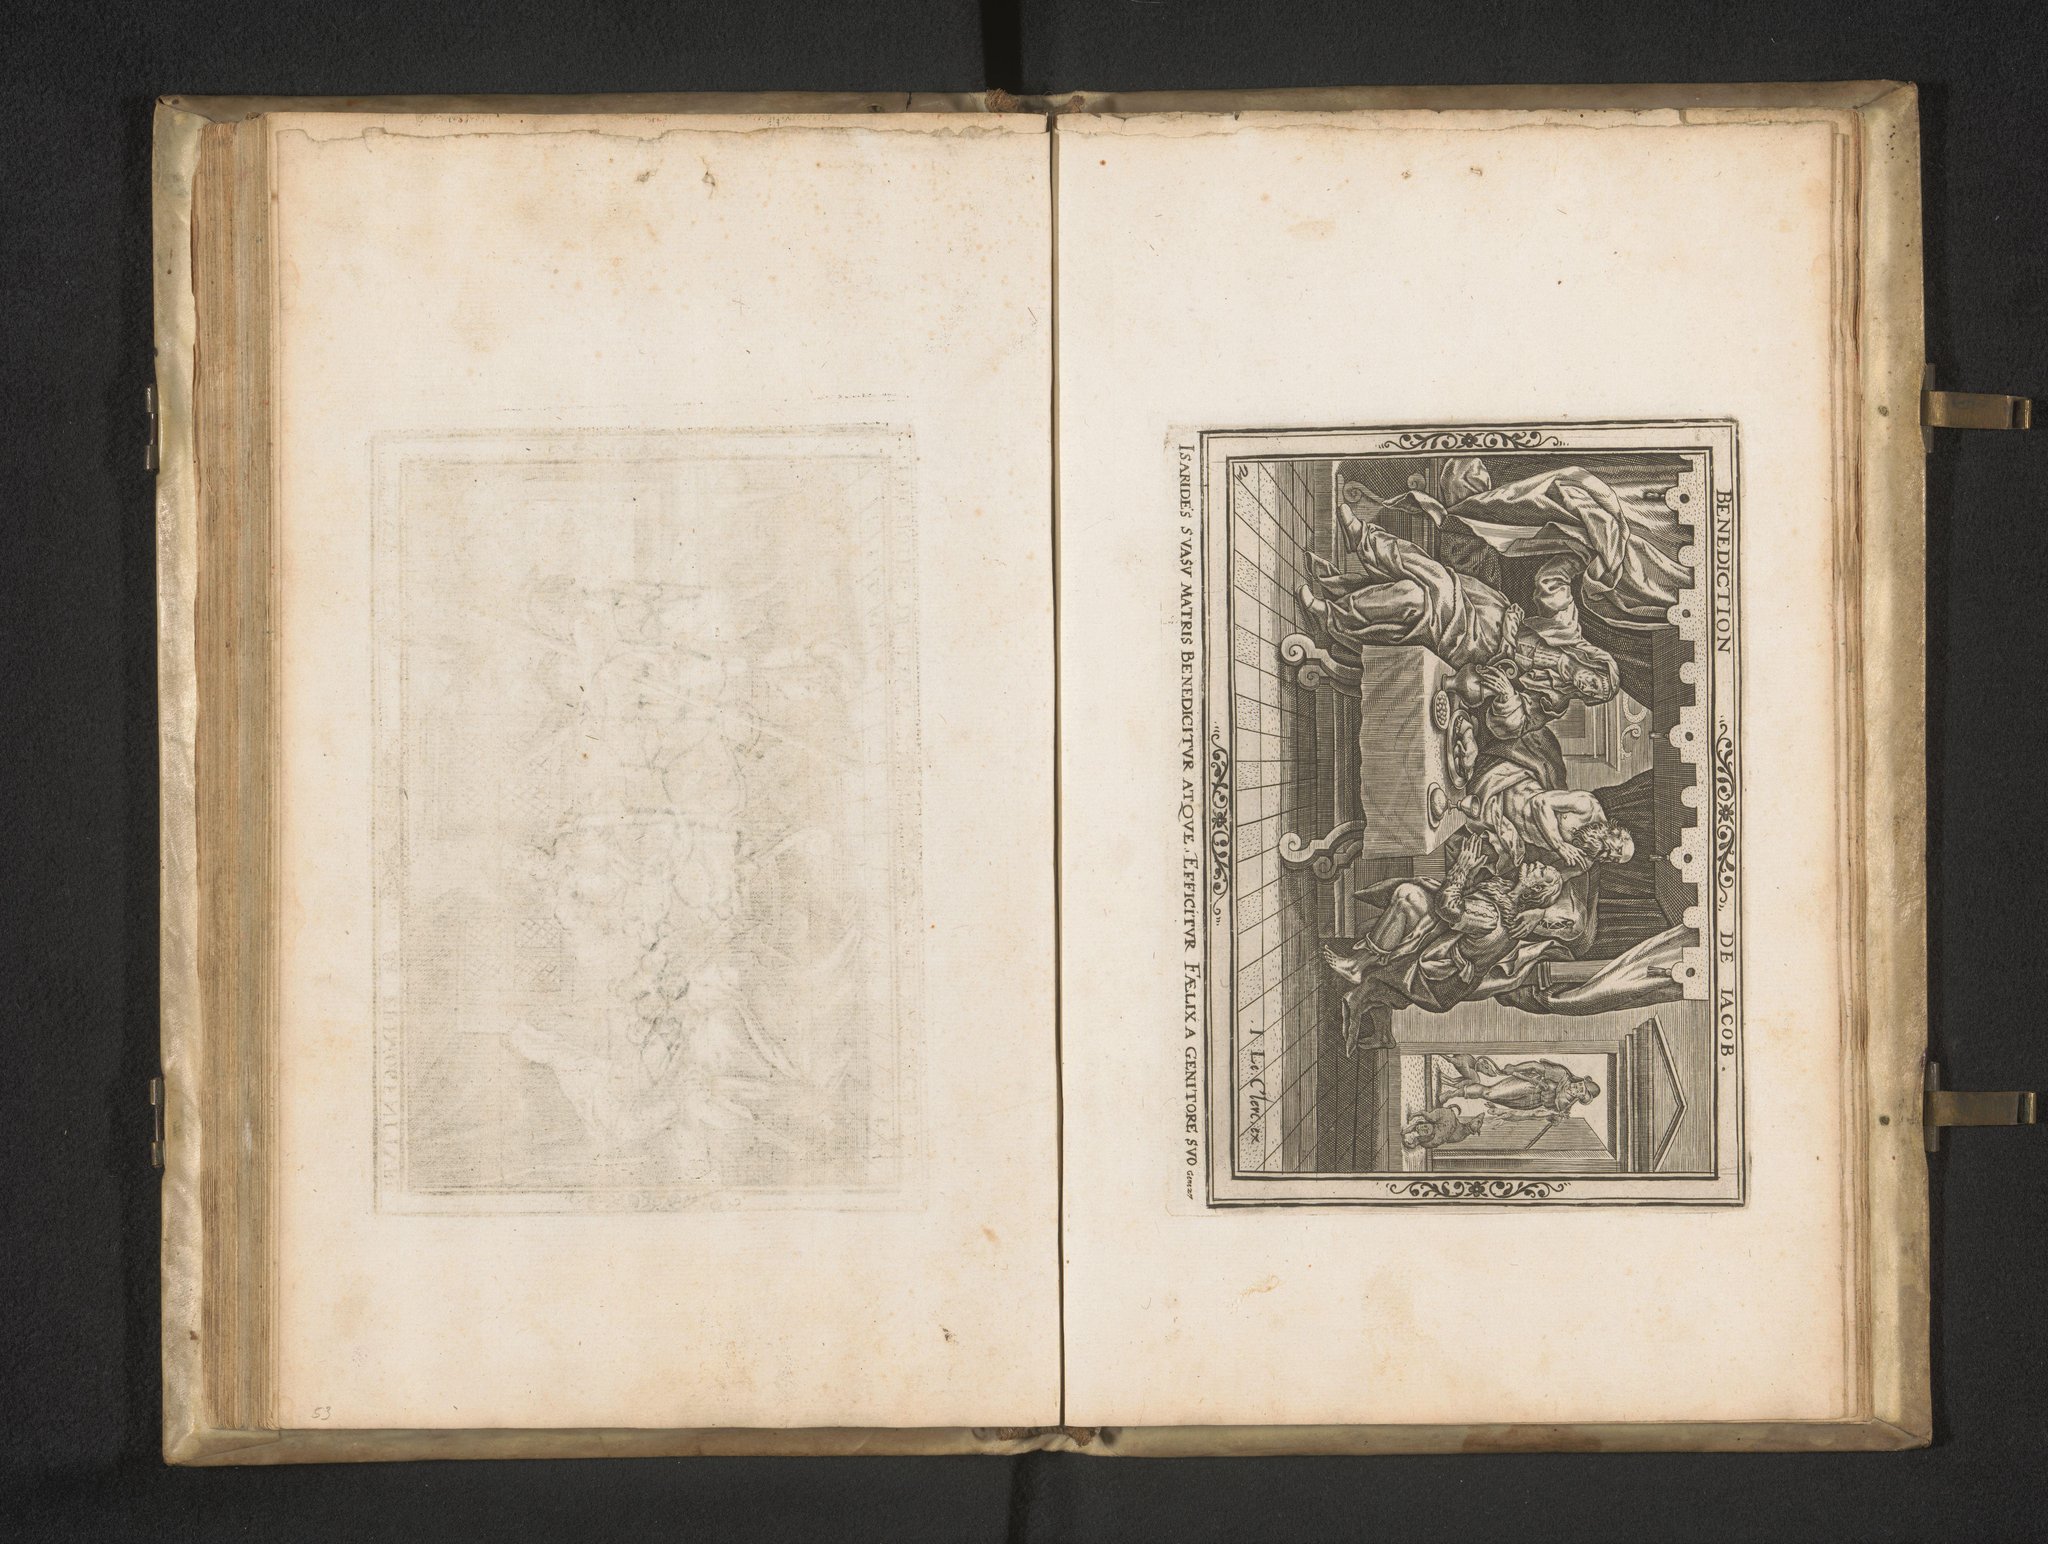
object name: print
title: Histoire de Esaeu et de Jacob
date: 1580-1621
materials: paper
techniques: engraving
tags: isaac lying in bed blesses jacob who, disguised in esau's clothes, brings food to his father; jacob's hands and neck are covered with goatskins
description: De oude en blinde Isaak zegent Jakob, die bij het bed knielt. Met hulp van zijn moeder Rebekka, die op de rand van het bed zit, heeft hij zich vermomd als zijn broer Esau om de zegen te kunnen ontvangen. In zijn nek en over zijn handen draagt Jakob het vel van een bokje om op zijn behaarde broer te lijken. Op de achtergrond keert Esau terug van de jacht. Onder de voorstelling een verwijzing in het Latijn naar de Bijbeltekst in Gen. 27. Onderdeel van een serie van 4 prenten van de geschiedenis van Jakob en Esau. Genummerd linksonder: 2. Onderdeel van een album met voornamelijk christelijke voorstellingen.